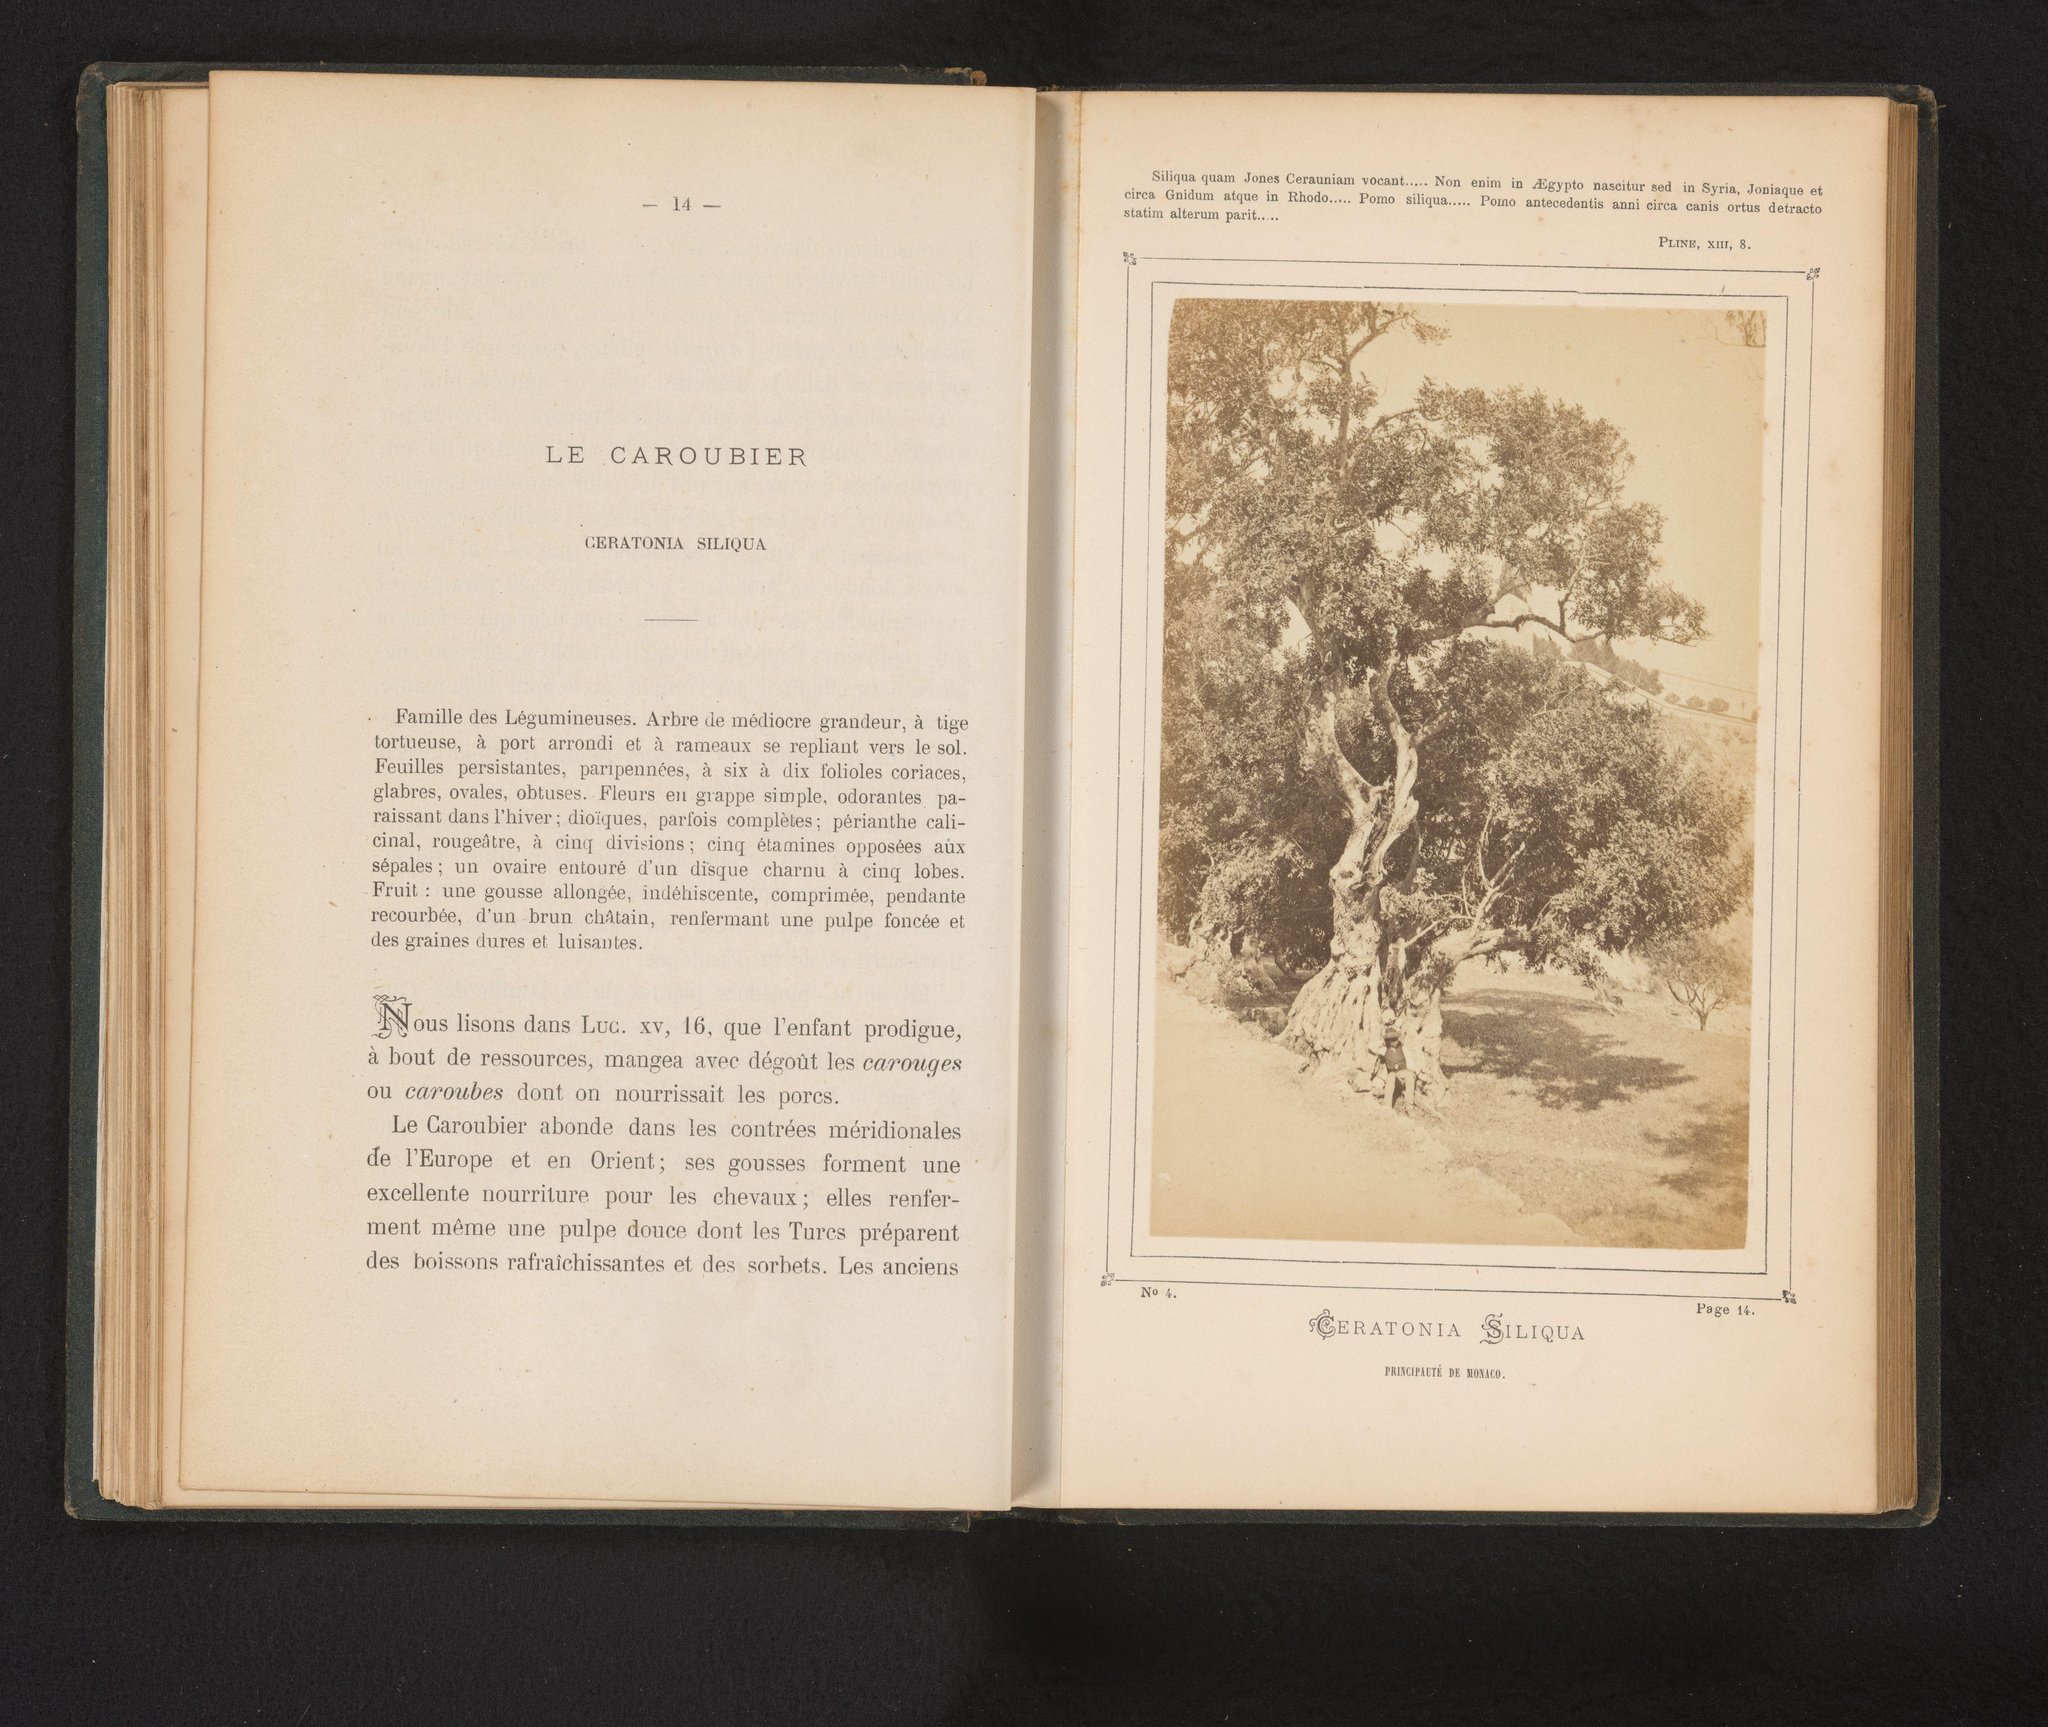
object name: page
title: Johannesbroodboom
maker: jean walburg de bray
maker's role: fotograaf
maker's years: 1839-1901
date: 1866-1871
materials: paper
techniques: albumen print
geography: monaco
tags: shrubs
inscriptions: number: ‘No 4.’, inscription: ‘Silinqua quam Jones Cerauniam vocant.... Non enim in AEgyto nascitur sed in Syria, Jonique et/ circa Gnidum atque in Rhodo.... Pomo siliqua.... Pomo antecedentis anni circa canis ortus detracto/ statim alterum parit.../ PLINE, XIII, 8.’, inscription: ‘Page 14.’